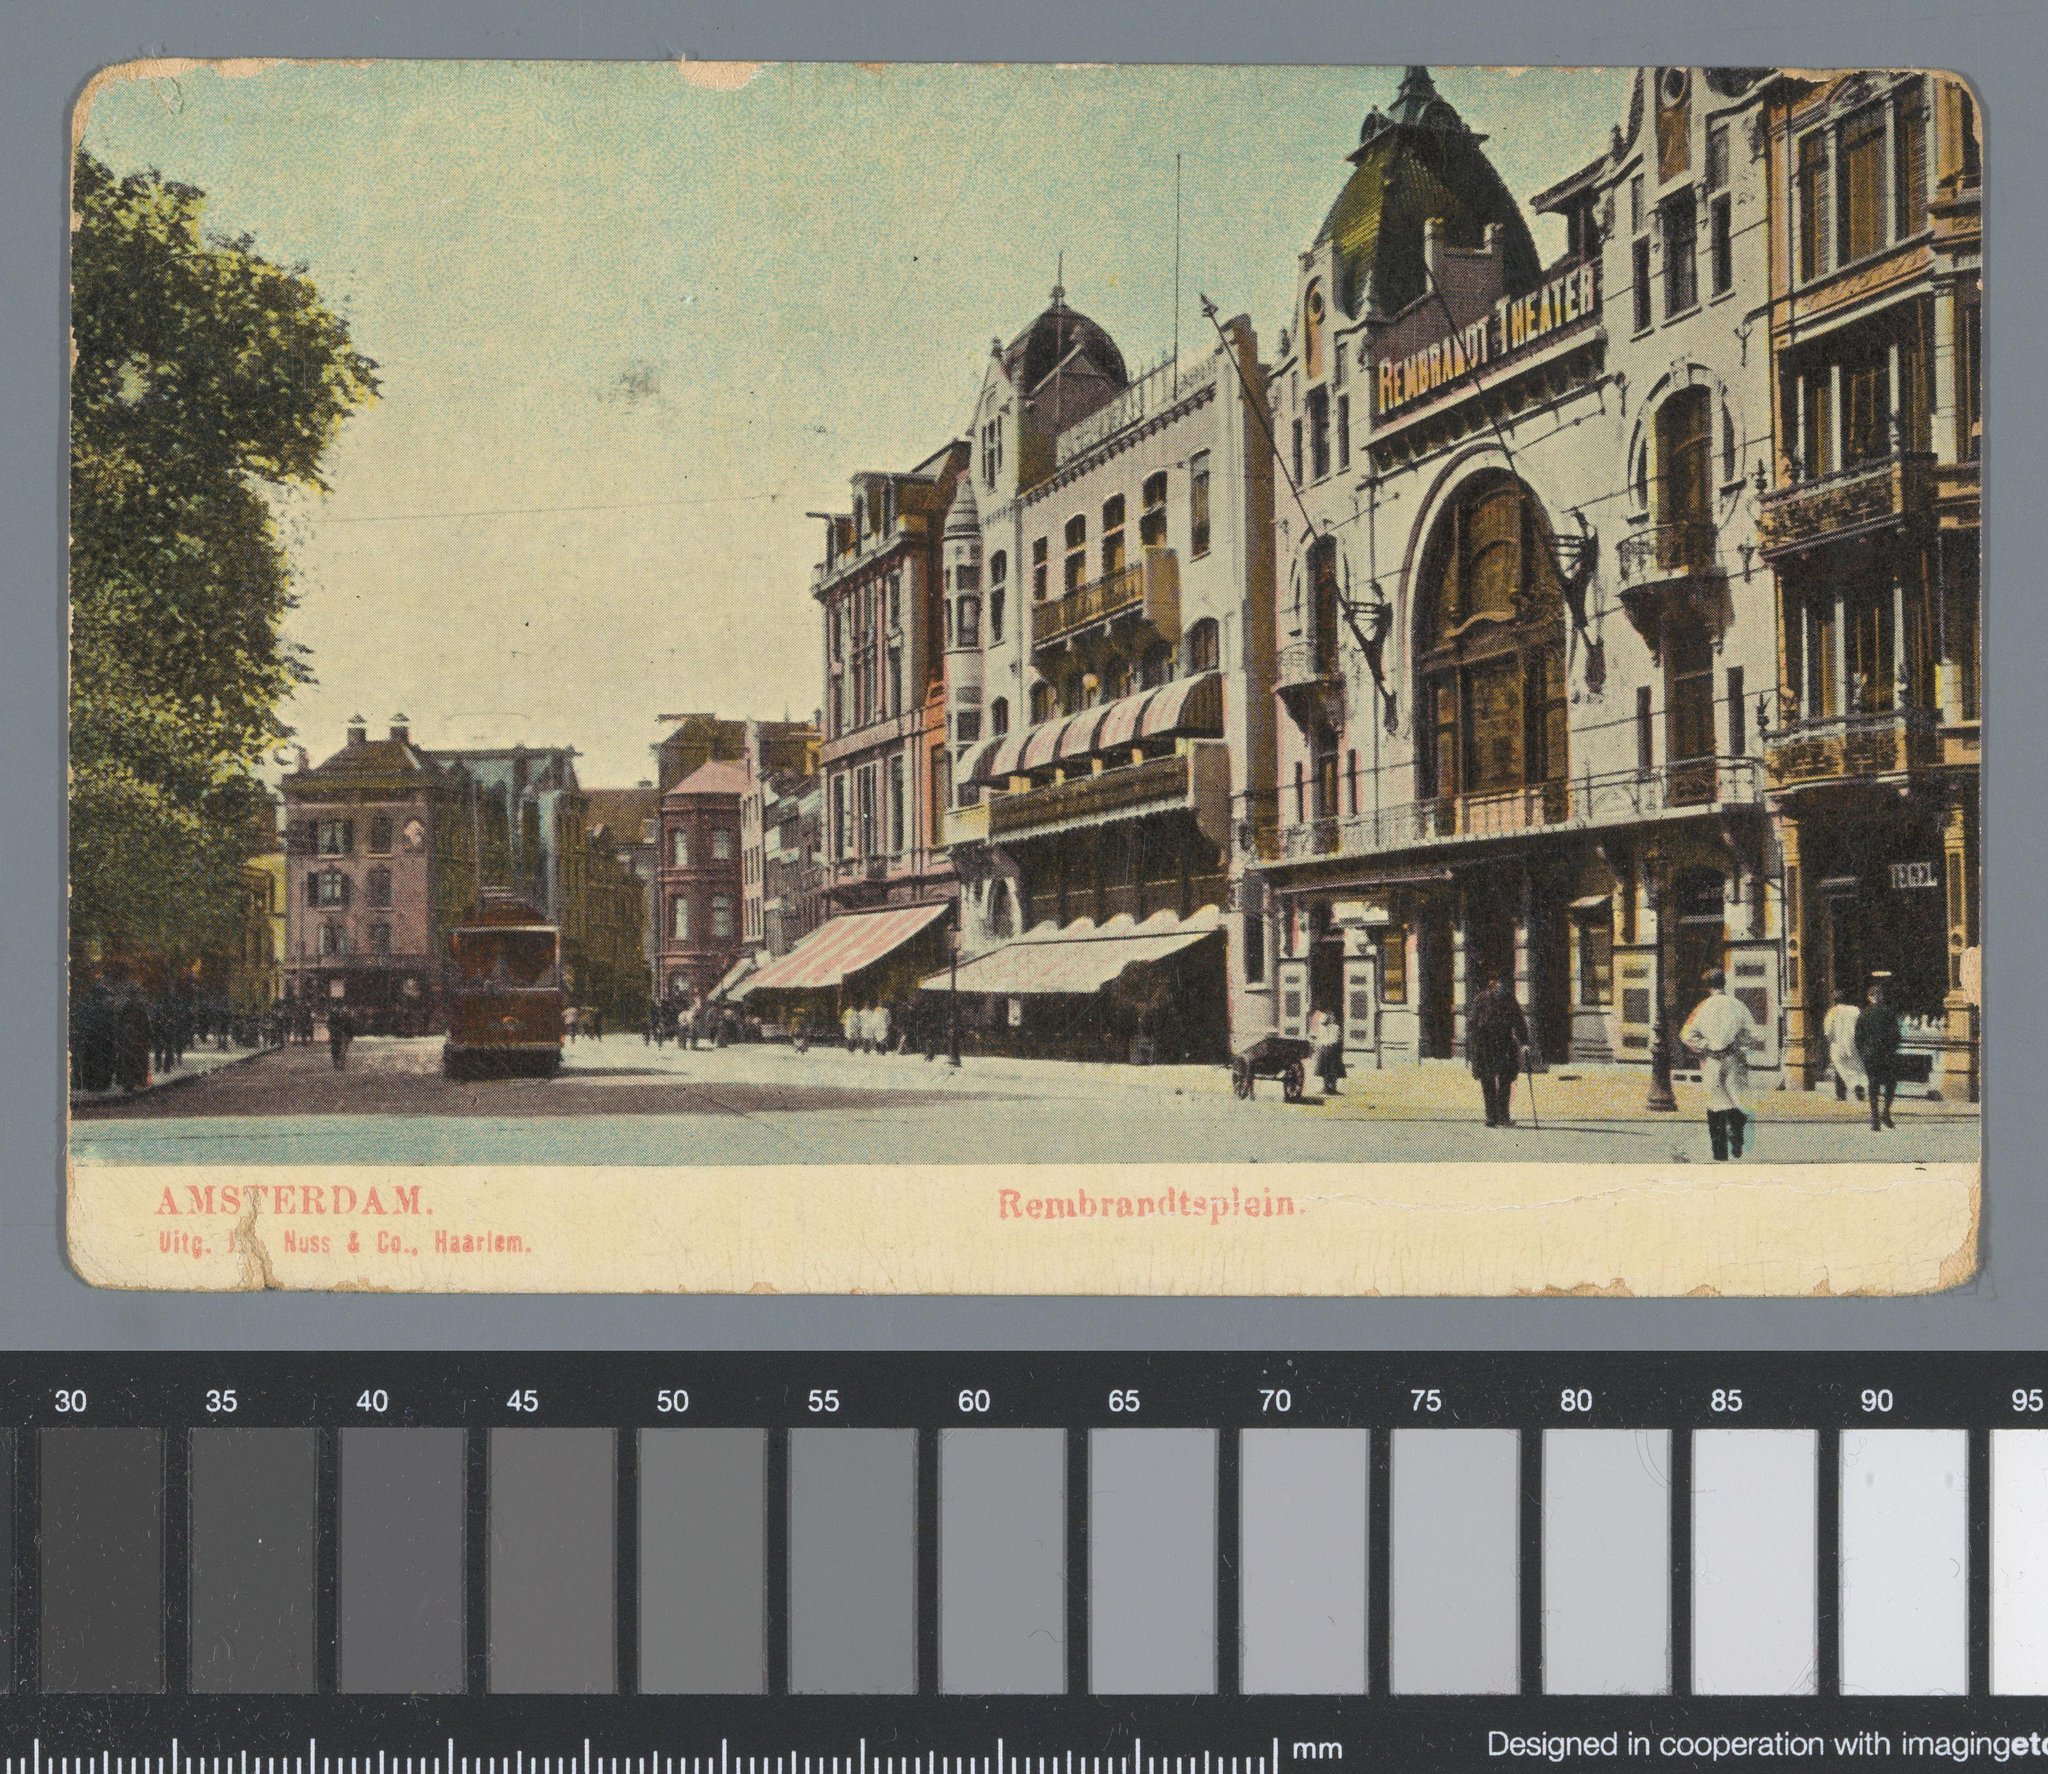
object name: ansichtkaart, prentbriefkaart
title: Amsterdam. Rembrandtsplein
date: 1907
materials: cardboard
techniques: writing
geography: haarlem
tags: square, place, circus, etc.